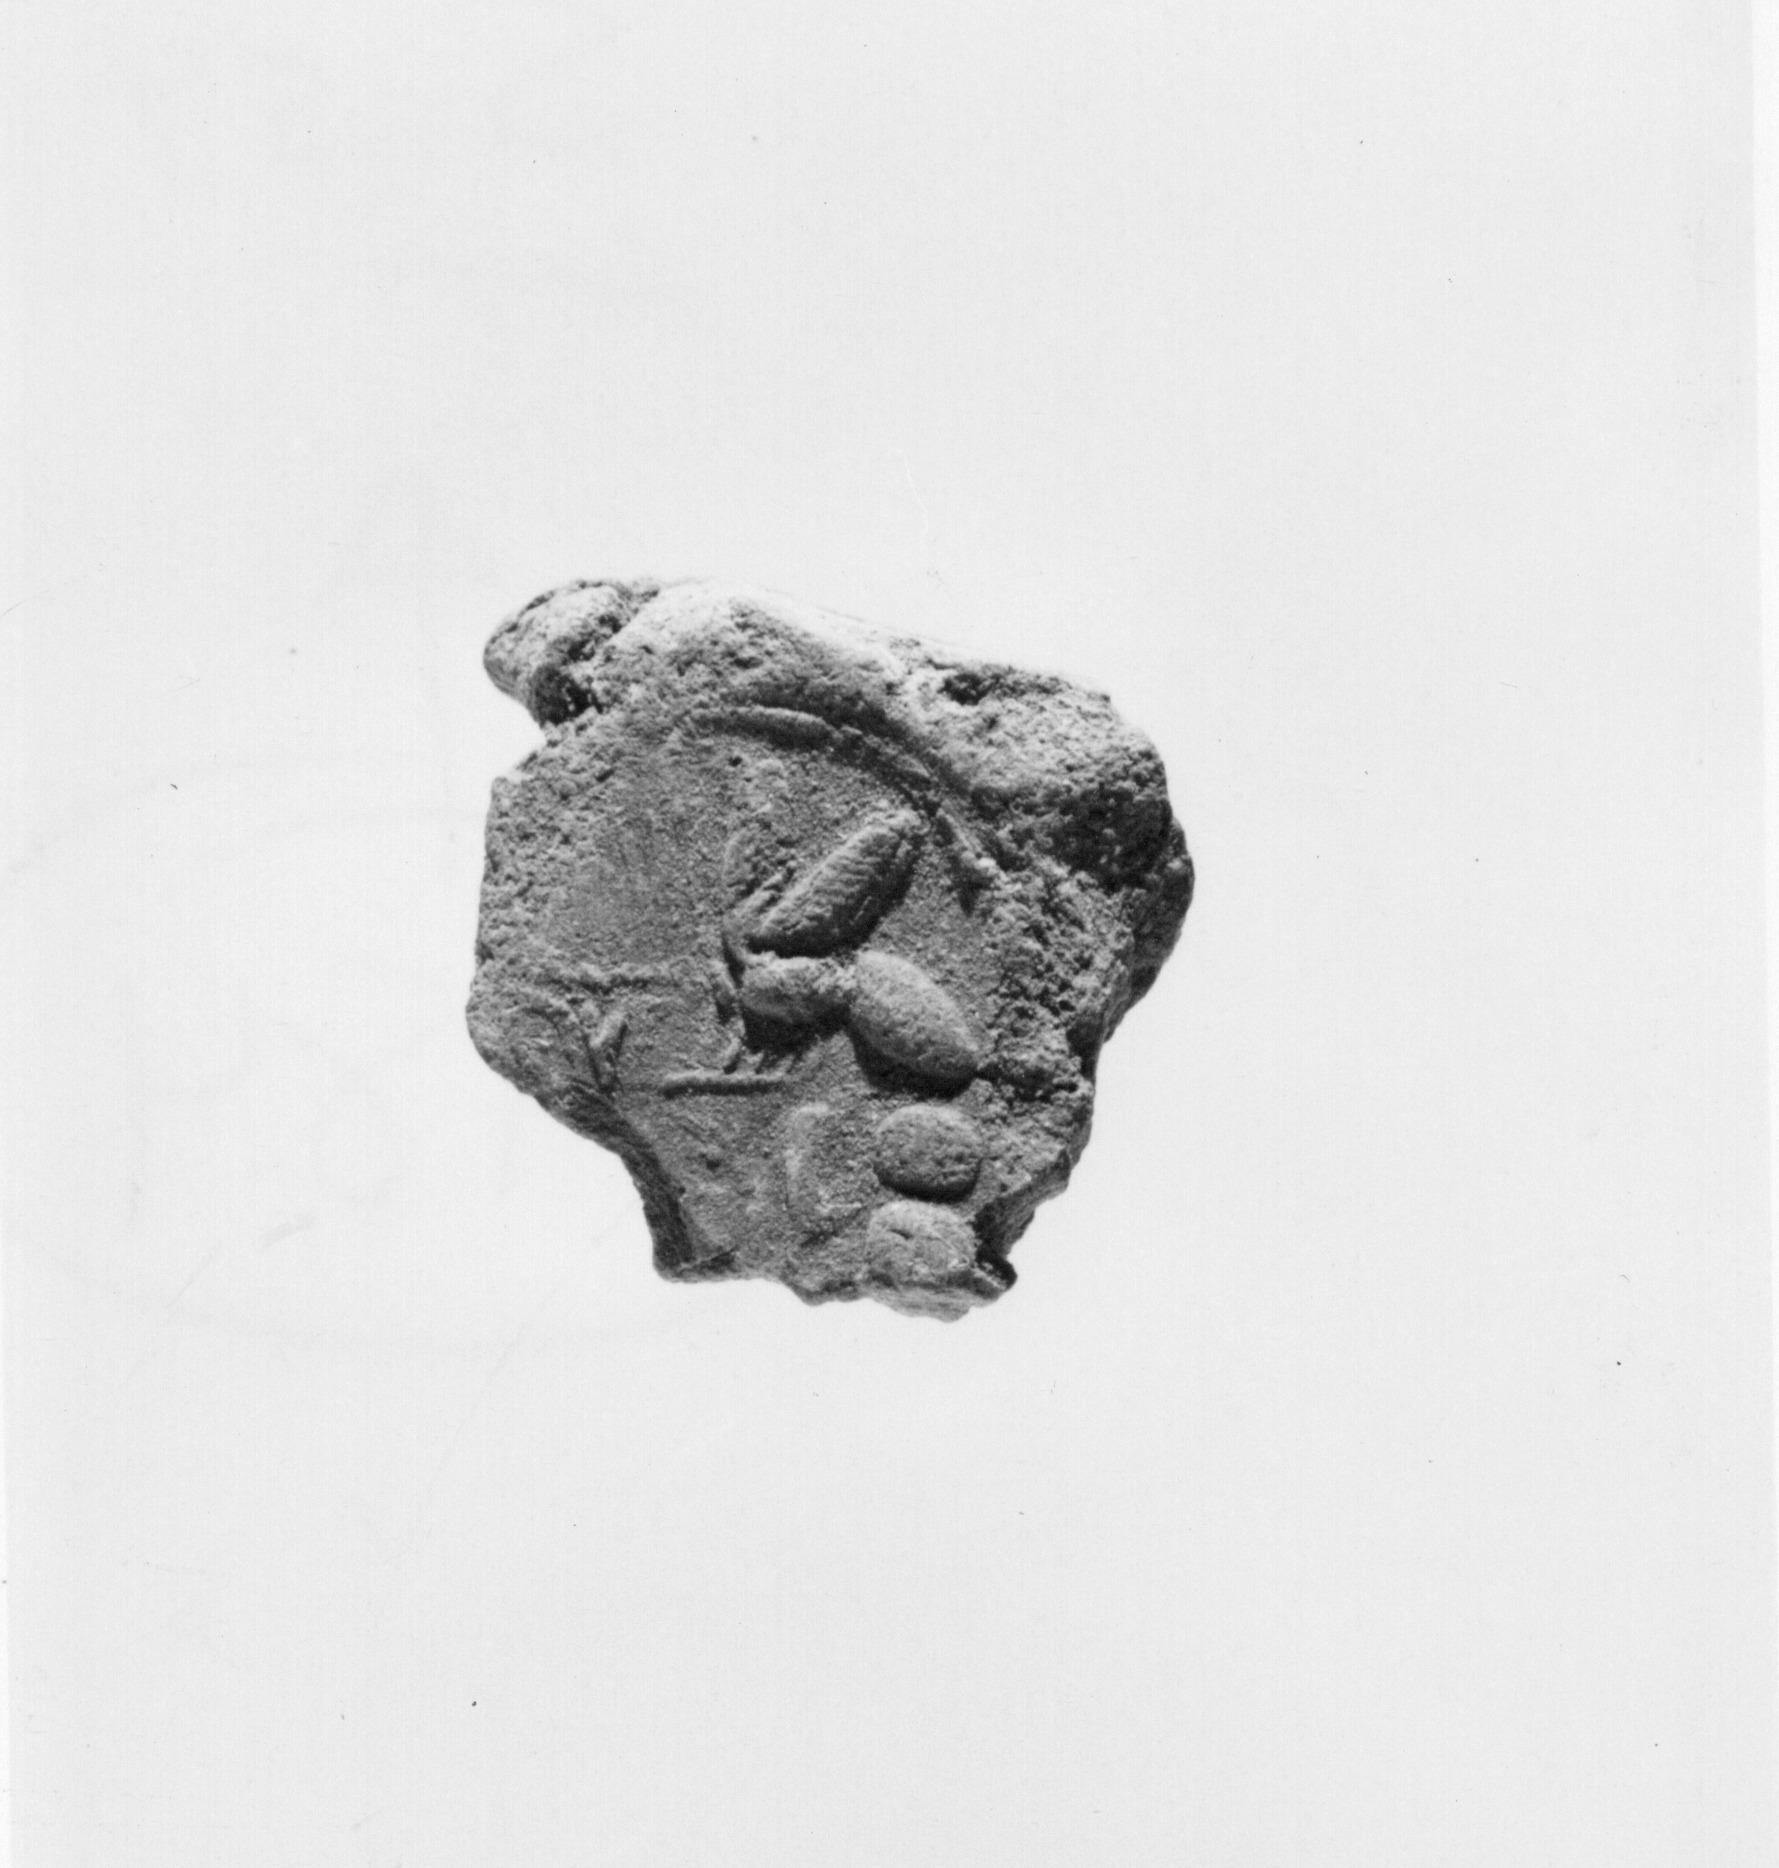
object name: sealing, nebmaatre, amenhotep iii, bee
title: Document Sealing With the Throne Name of Amenhotep III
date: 1390-1352 BCE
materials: mud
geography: egypt